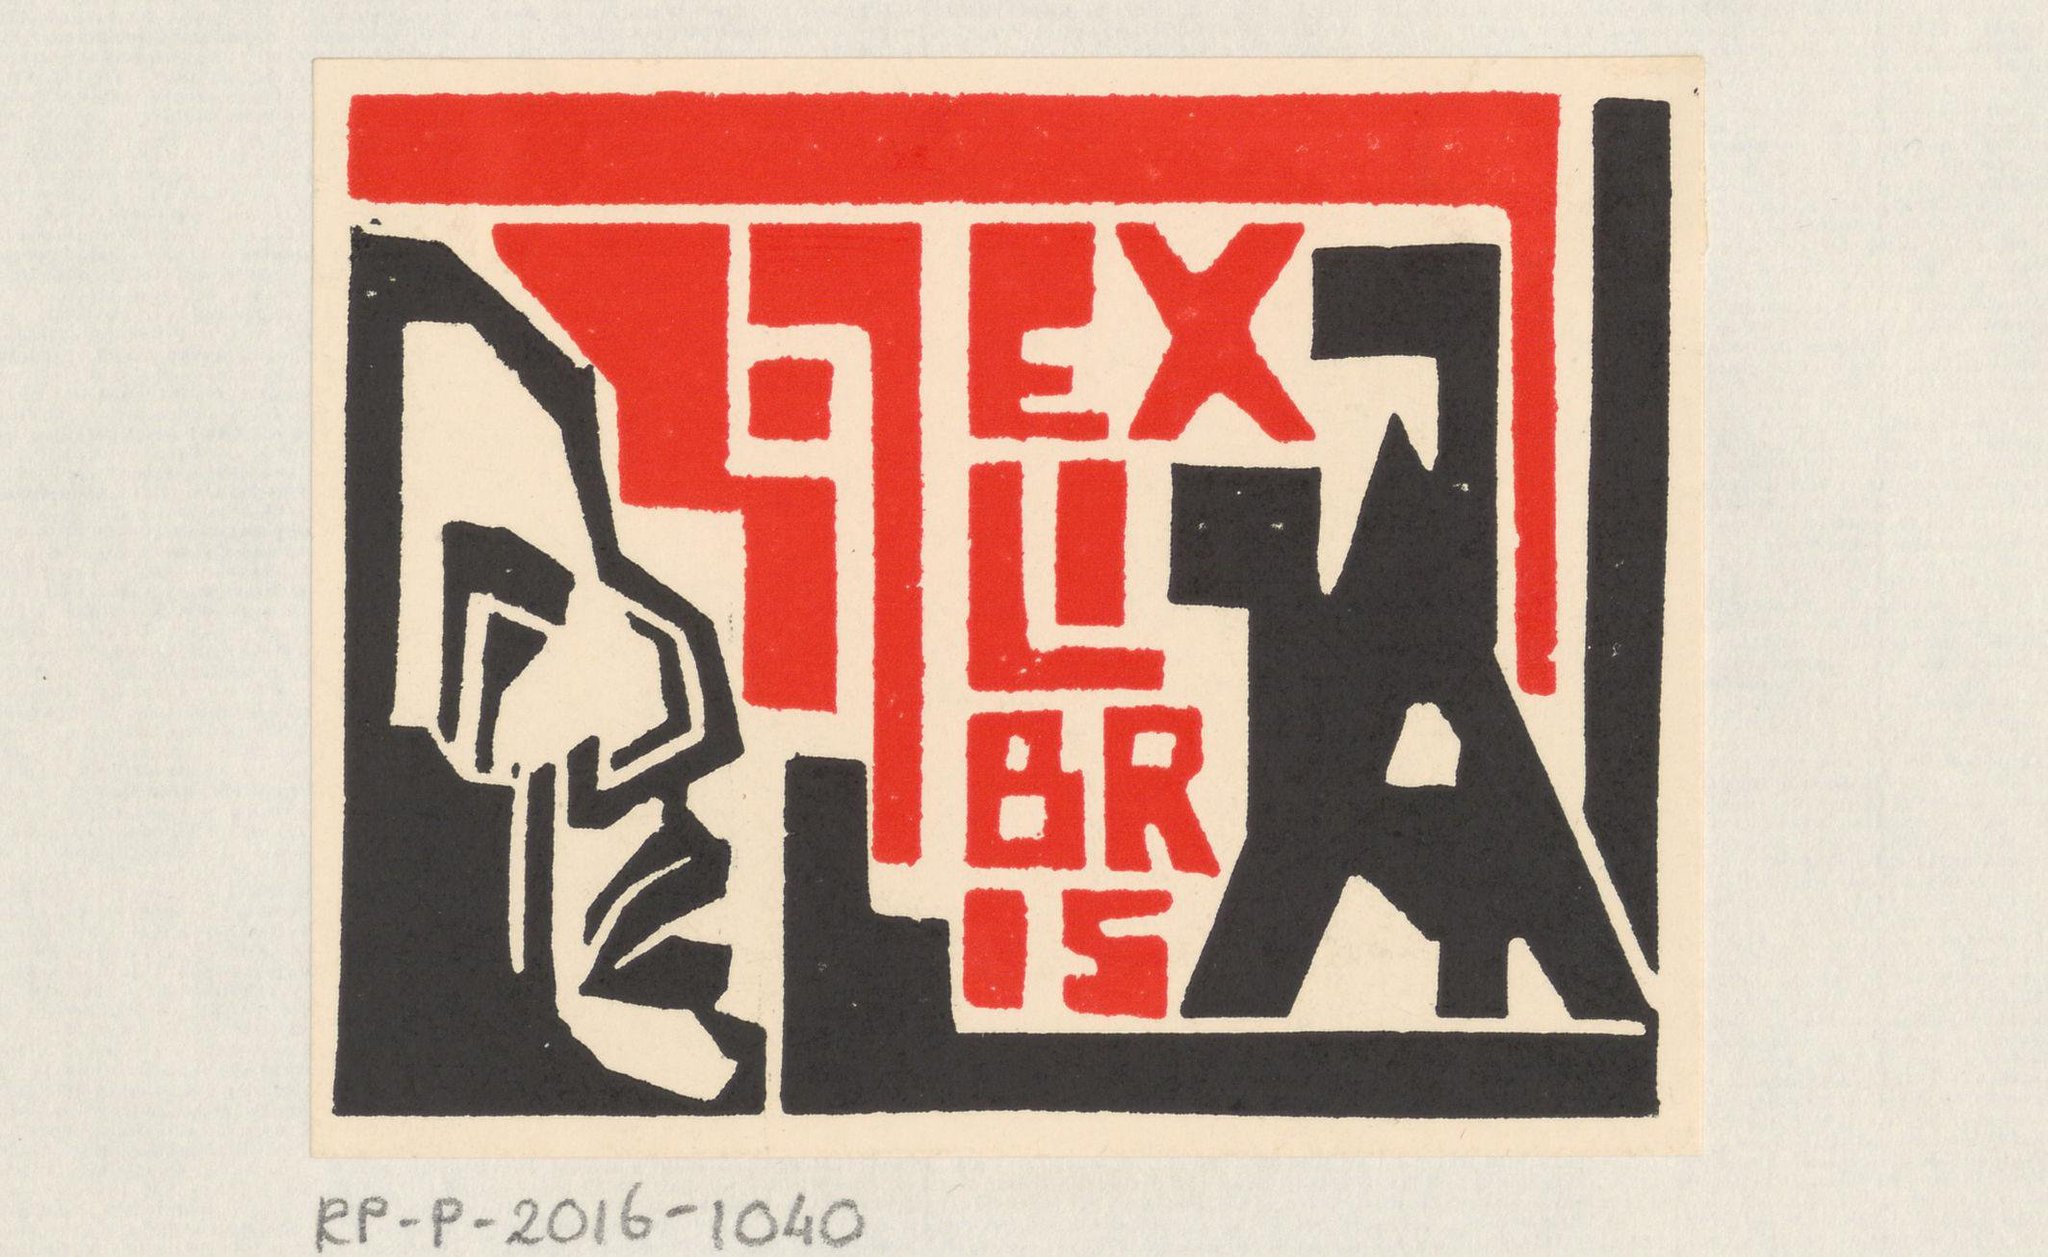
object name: bookplate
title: Ex libris van J.J.A.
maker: hans van mastenbroek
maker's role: draughtsman, print maker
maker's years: 1900-1934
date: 1915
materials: paper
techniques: linocut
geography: south holland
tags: face (+ sideview, profile)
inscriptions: date